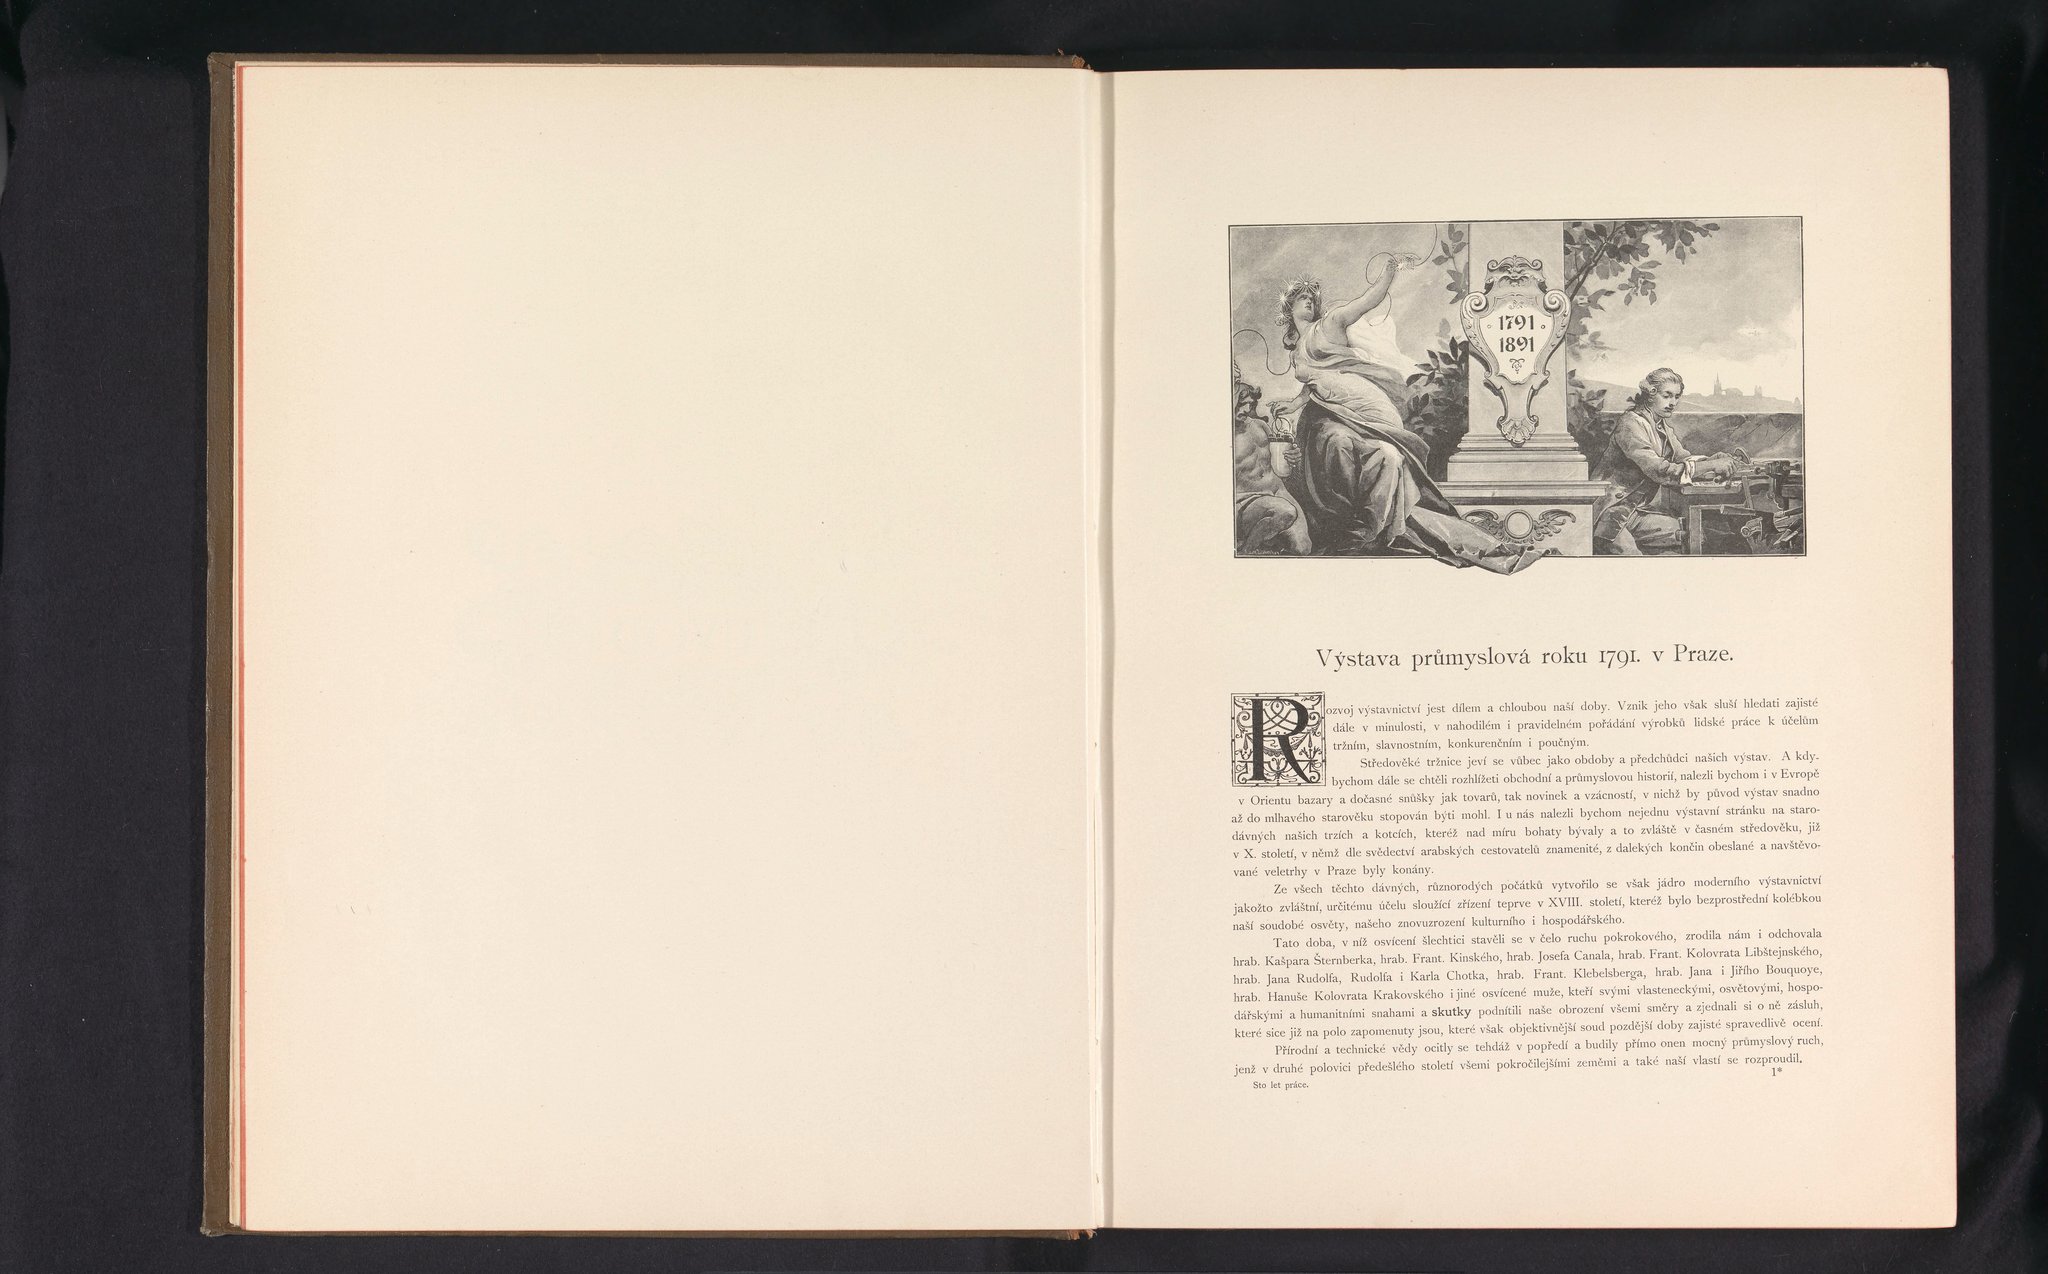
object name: reproduction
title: Fotoreproductie van een tekening, voorstellende een personificatie van de Tsjechische Republiek creëert elektriciteit en een beeldhouwer aan het werk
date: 1888-1893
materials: paper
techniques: autotype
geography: prague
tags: sculptor at work, spark ~ electricity